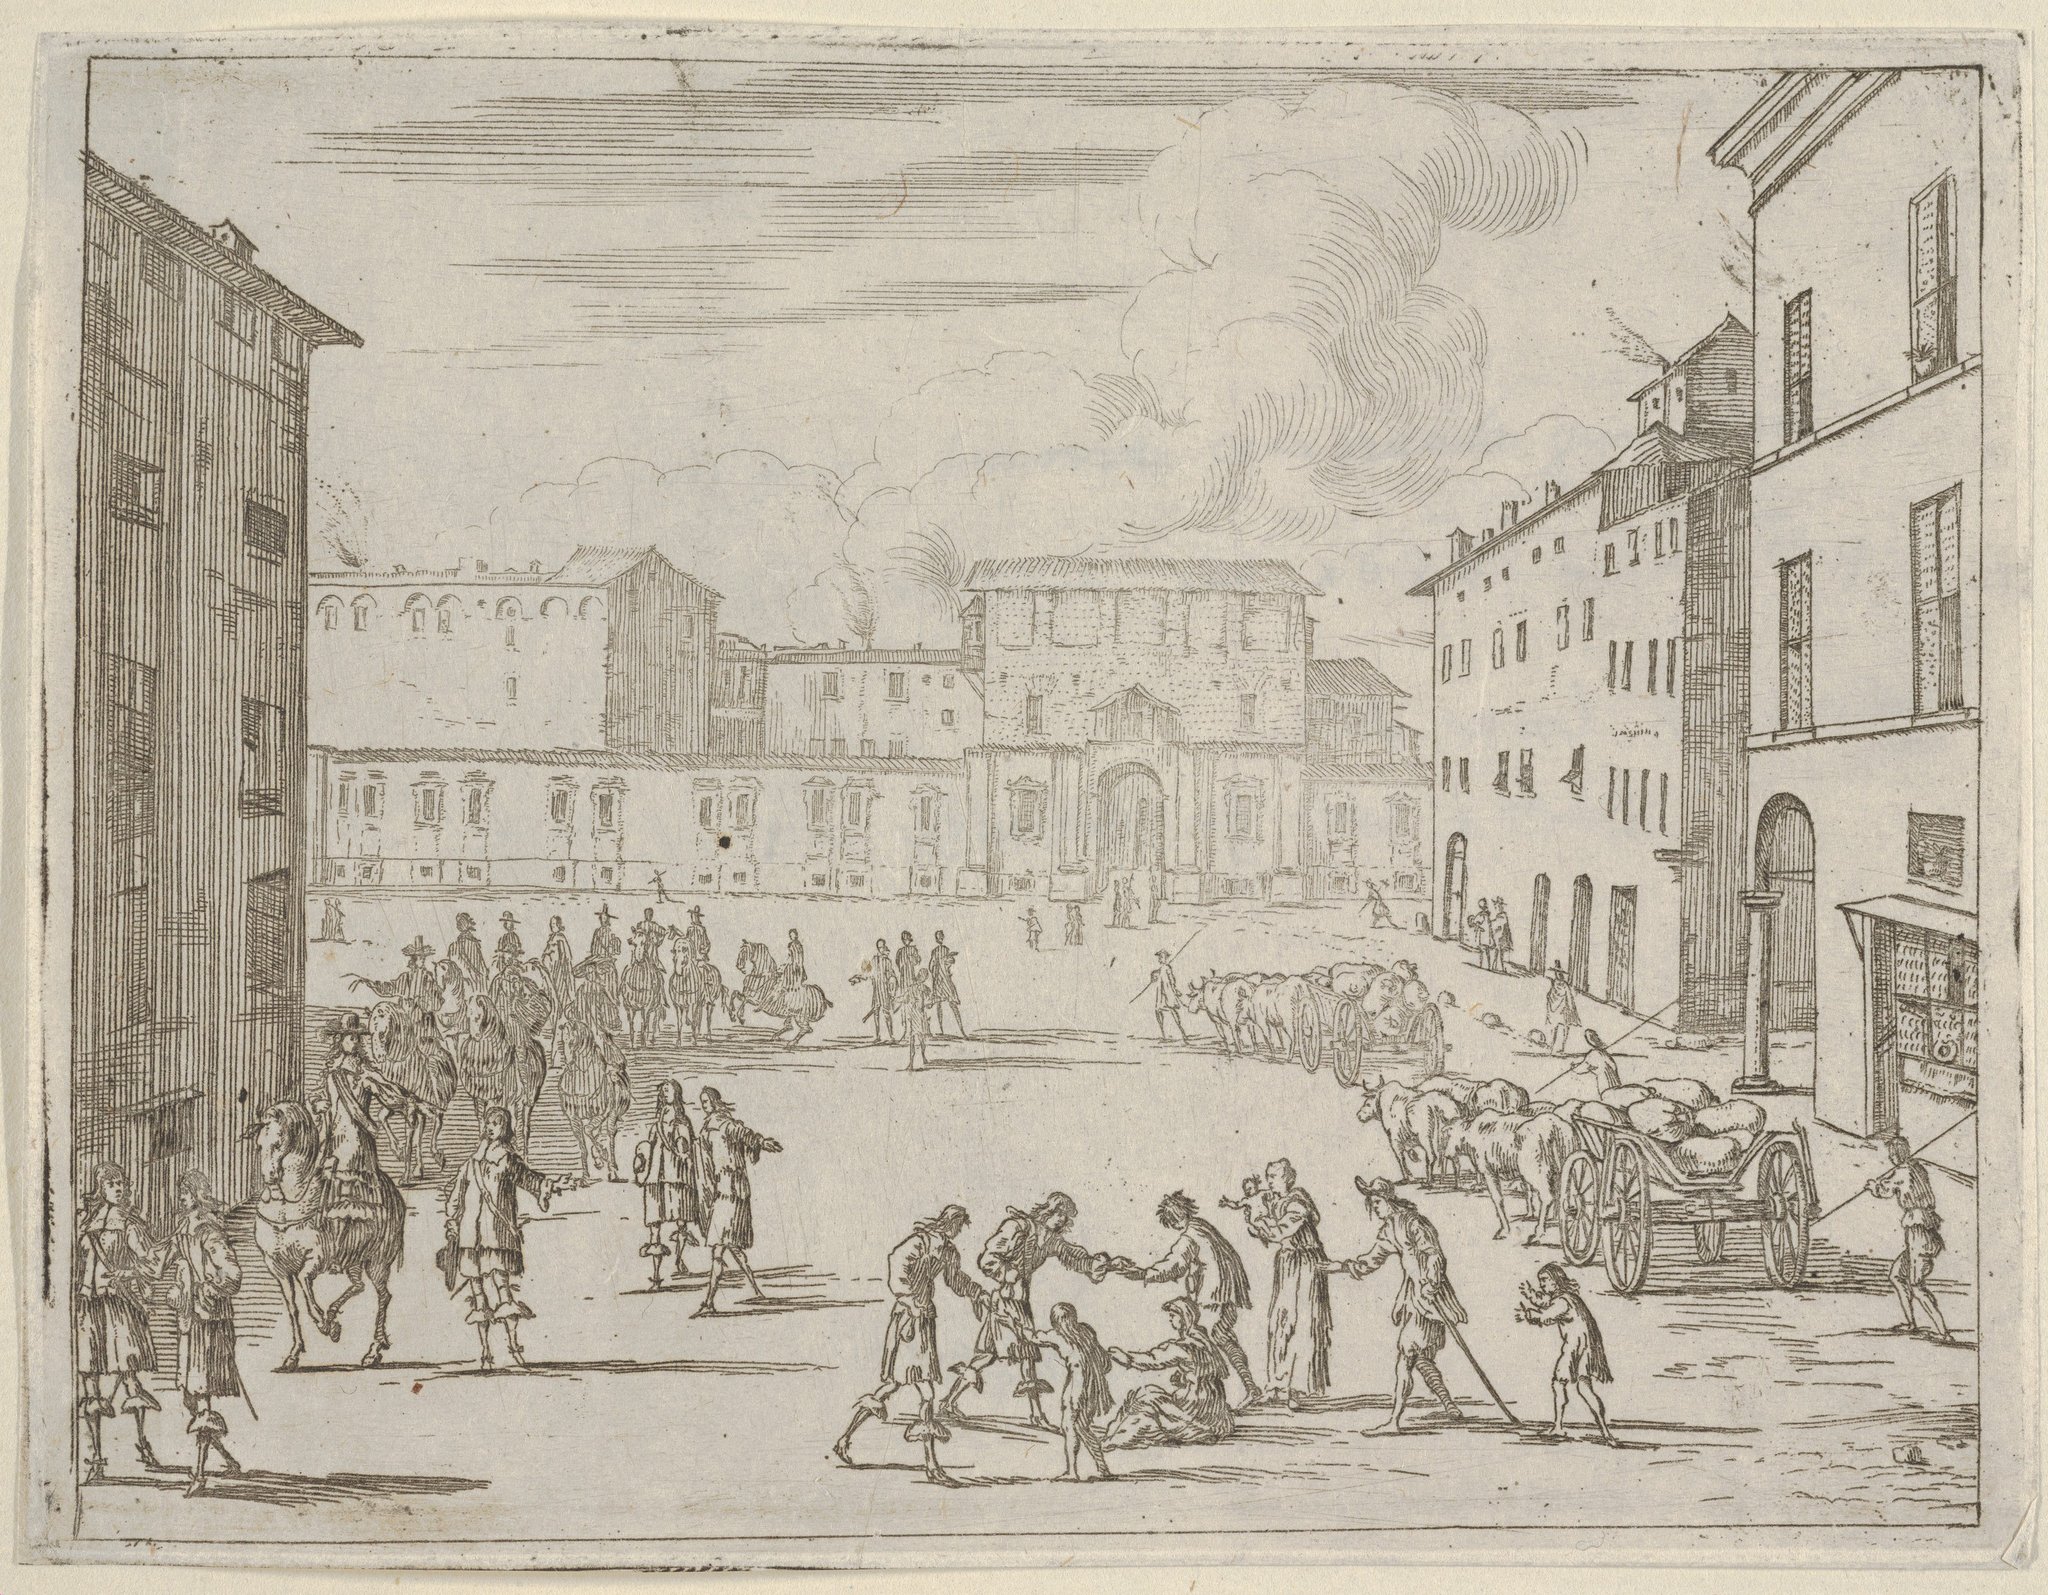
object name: print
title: Francesco I d'Este Assists His Subjects with Great Generosity During the Great Famine of 1648 and 1649, from "L'Idea di un Principe ed Eroe Cristiano in Francesco I d'Este, di Modena e Reggio Duca VIII [...]"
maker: bartolomeo fenice (fénis)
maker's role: artist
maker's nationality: italian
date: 1659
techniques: etching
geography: italy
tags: human figures,buildings,horses